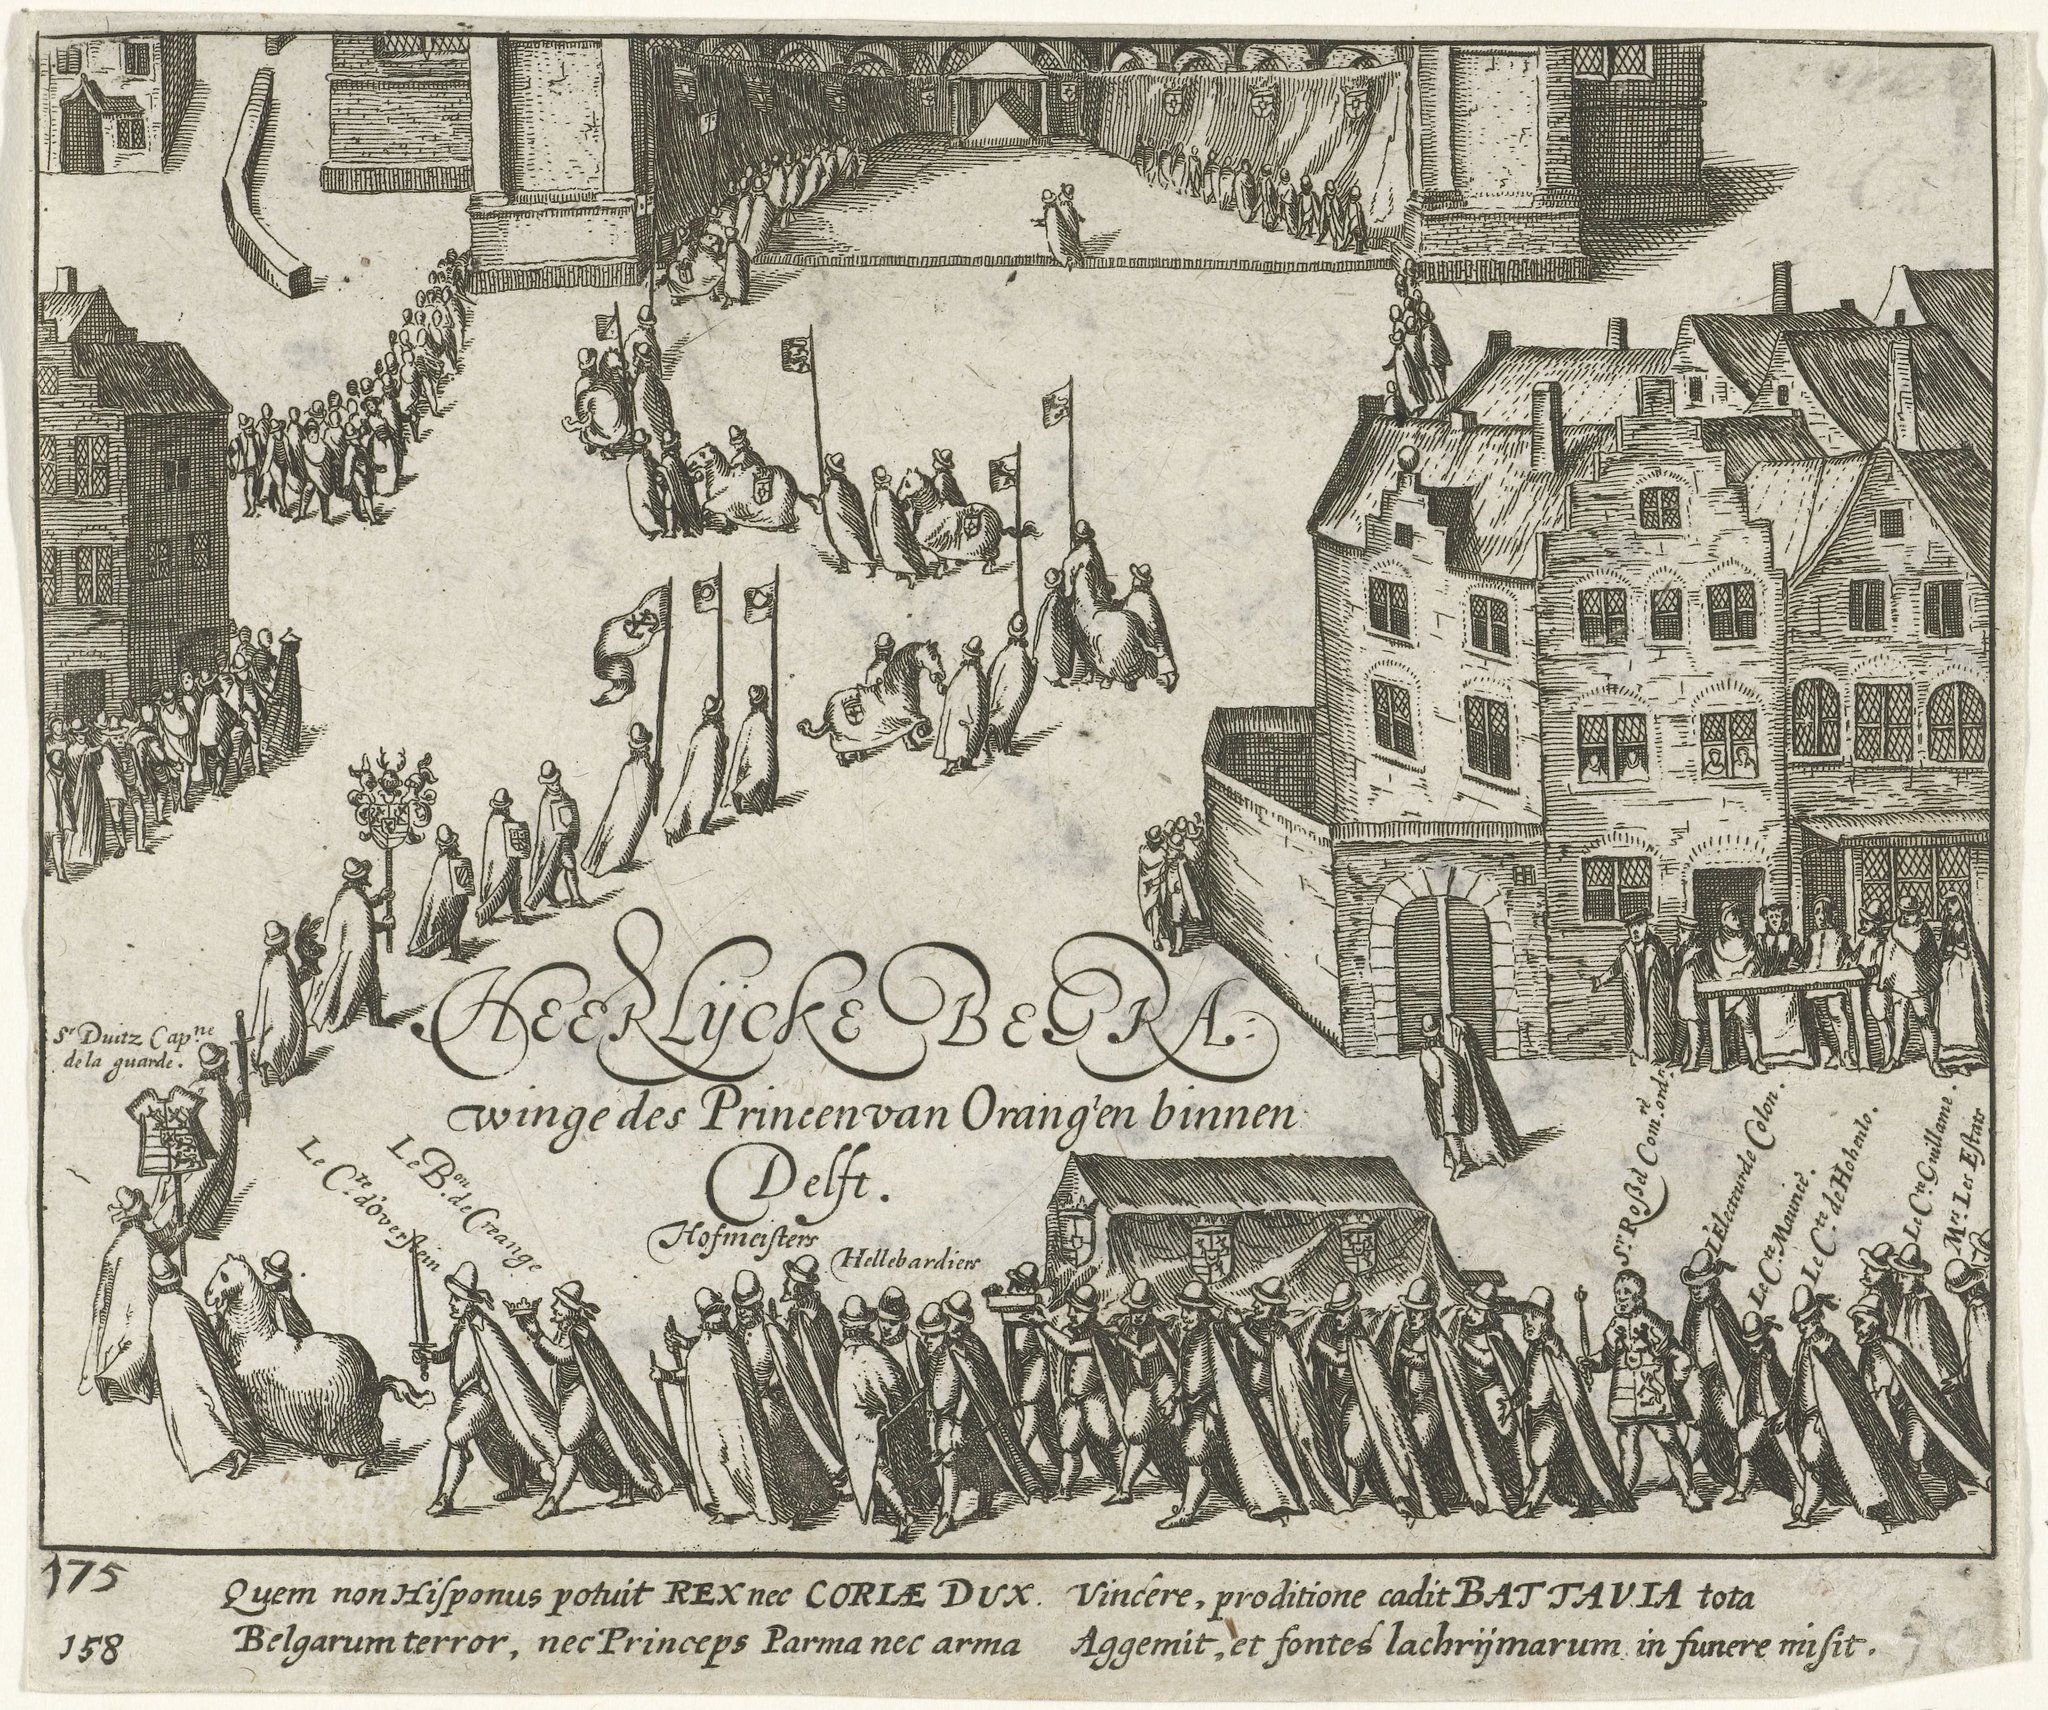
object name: history print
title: Heerlijcke Begrawinge des Princen van Orangien binnen Delft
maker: Anonymous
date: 1613-1615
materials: paper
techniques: etching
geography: northern netherlands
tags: delft, william i (prince of orange), cortege, funeral procession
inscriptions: collector's mark: Lugt 240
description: Lijkstatie en begrafenis van Willem van Oranje te Delft, 3 augustus 1584. Begrafenisstoet met lijkkist slingert door de straten van Delft naar de Nieuwe Kerk. Verschillende leden van de stoet met naam aangeduid. Met onderschrift van 4 regels in het Latijn. Genummerd 158 en 175. Onbedrukt op achterzijde.